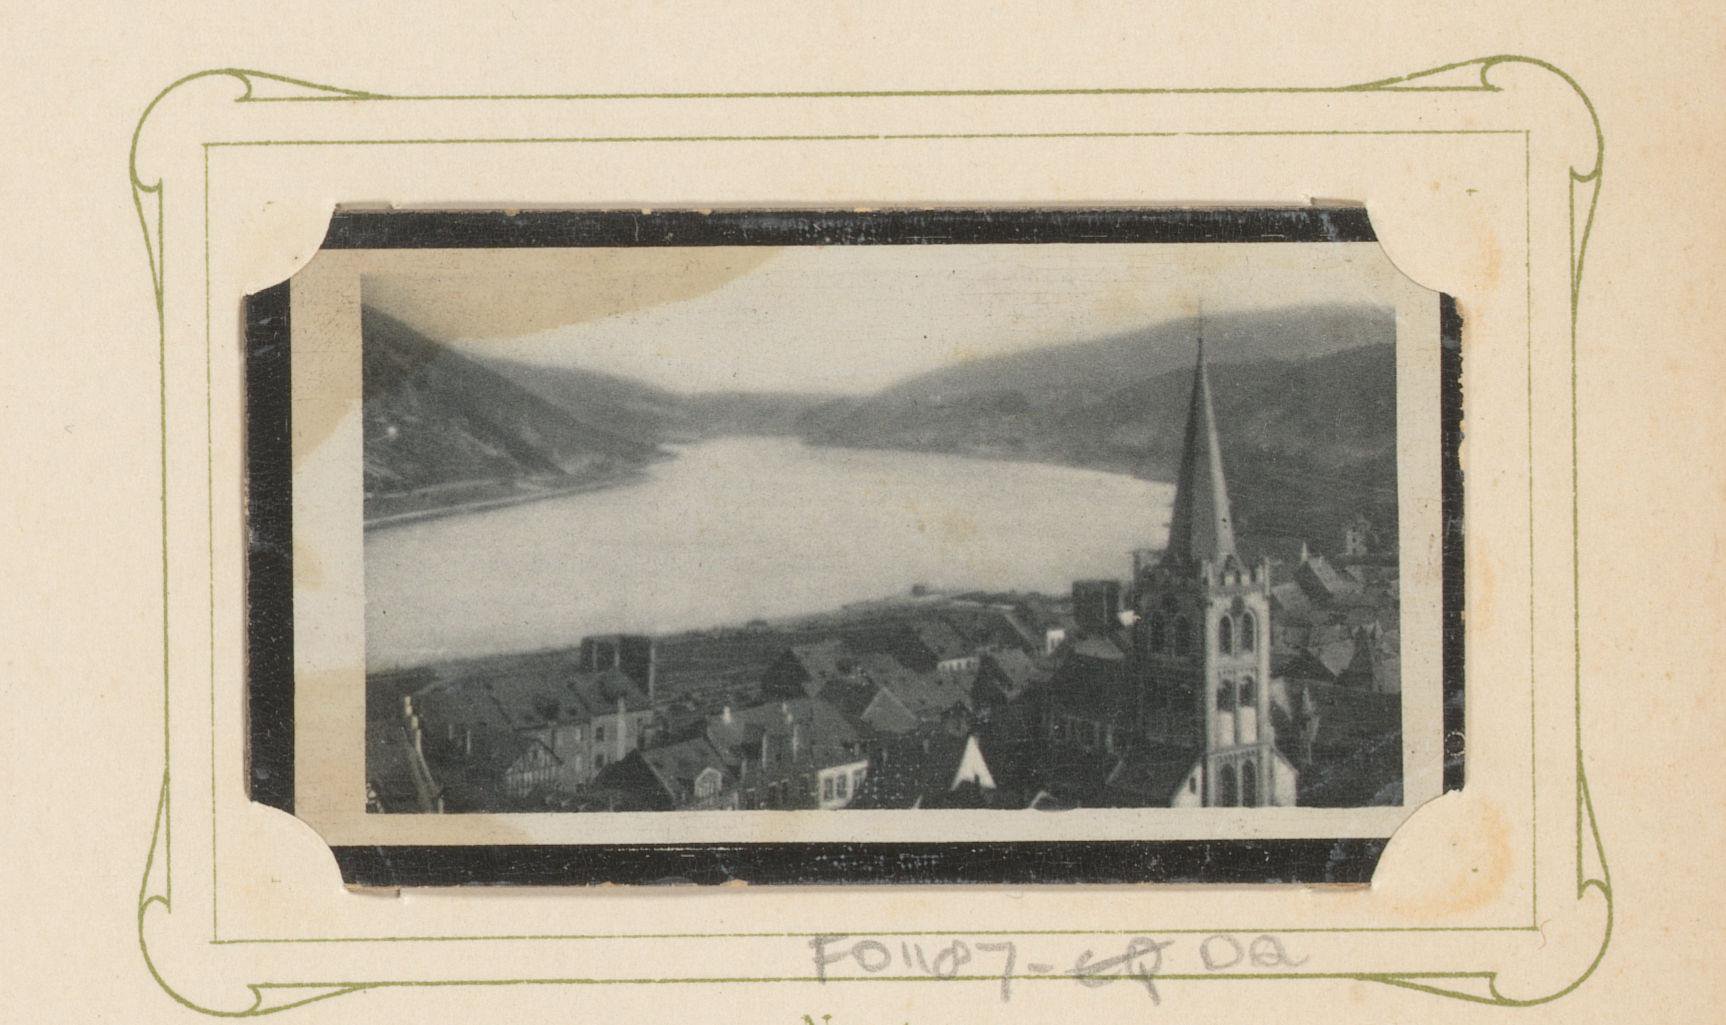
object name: album leaf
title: Gezicht op Bacharach, Duitsland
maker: Anonymous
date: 1905-1906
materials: paper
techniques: photograph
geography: bacharach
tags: prospect of village, silhouette of village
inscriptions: inscription: ‘No. 4./ Bacharach.’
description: Deze prent maakt deel uit van een album.